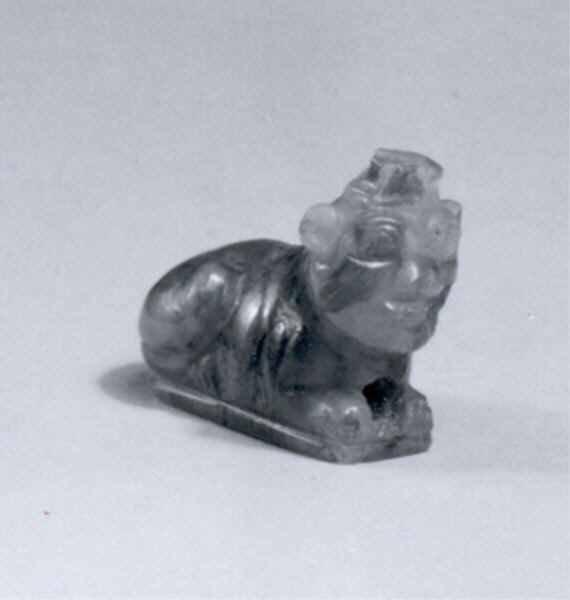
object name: necklace, bead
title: Lion amulet with human head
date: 1000-1 BCE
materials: stone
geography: syria